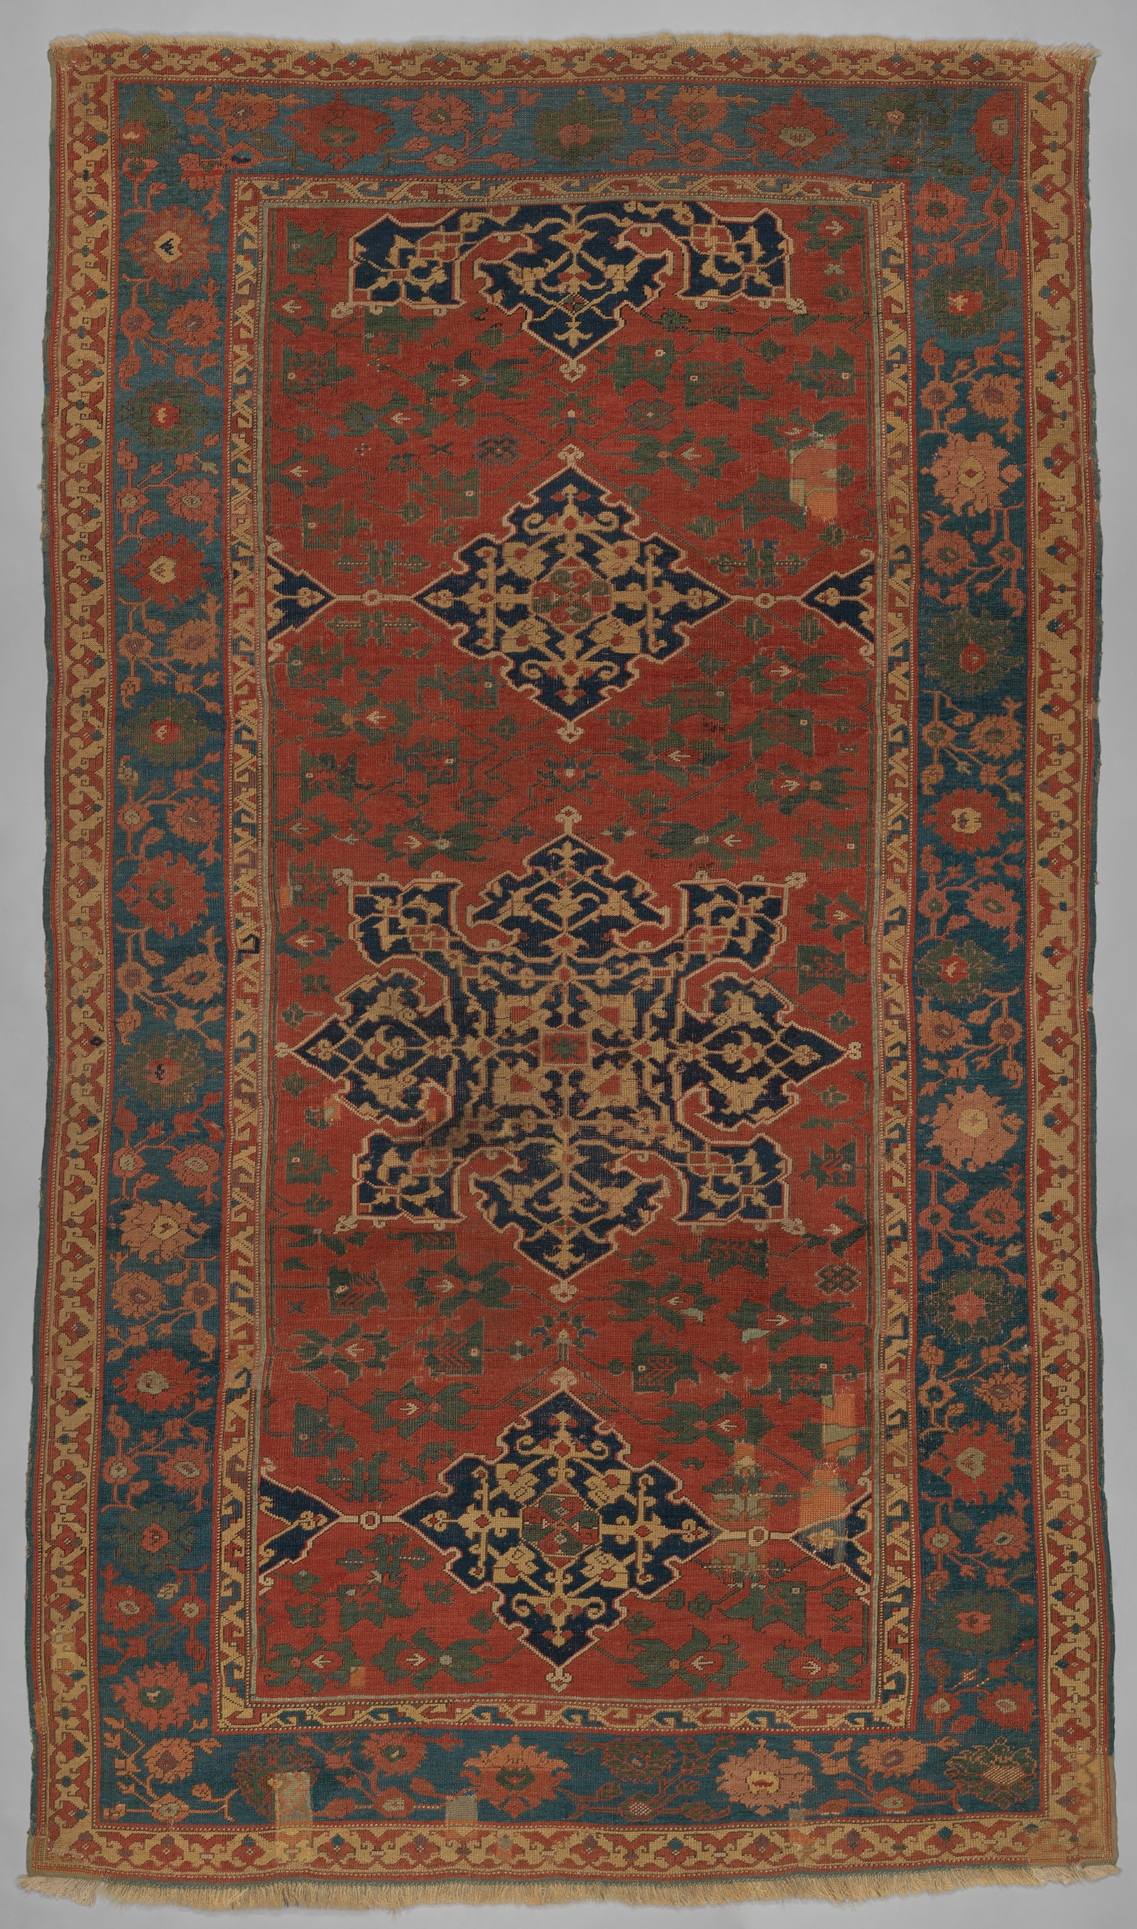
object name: carpet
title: "Star Ushak" Carpet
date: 1601-1700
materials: wool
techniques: pile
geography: western turkey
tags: flowers